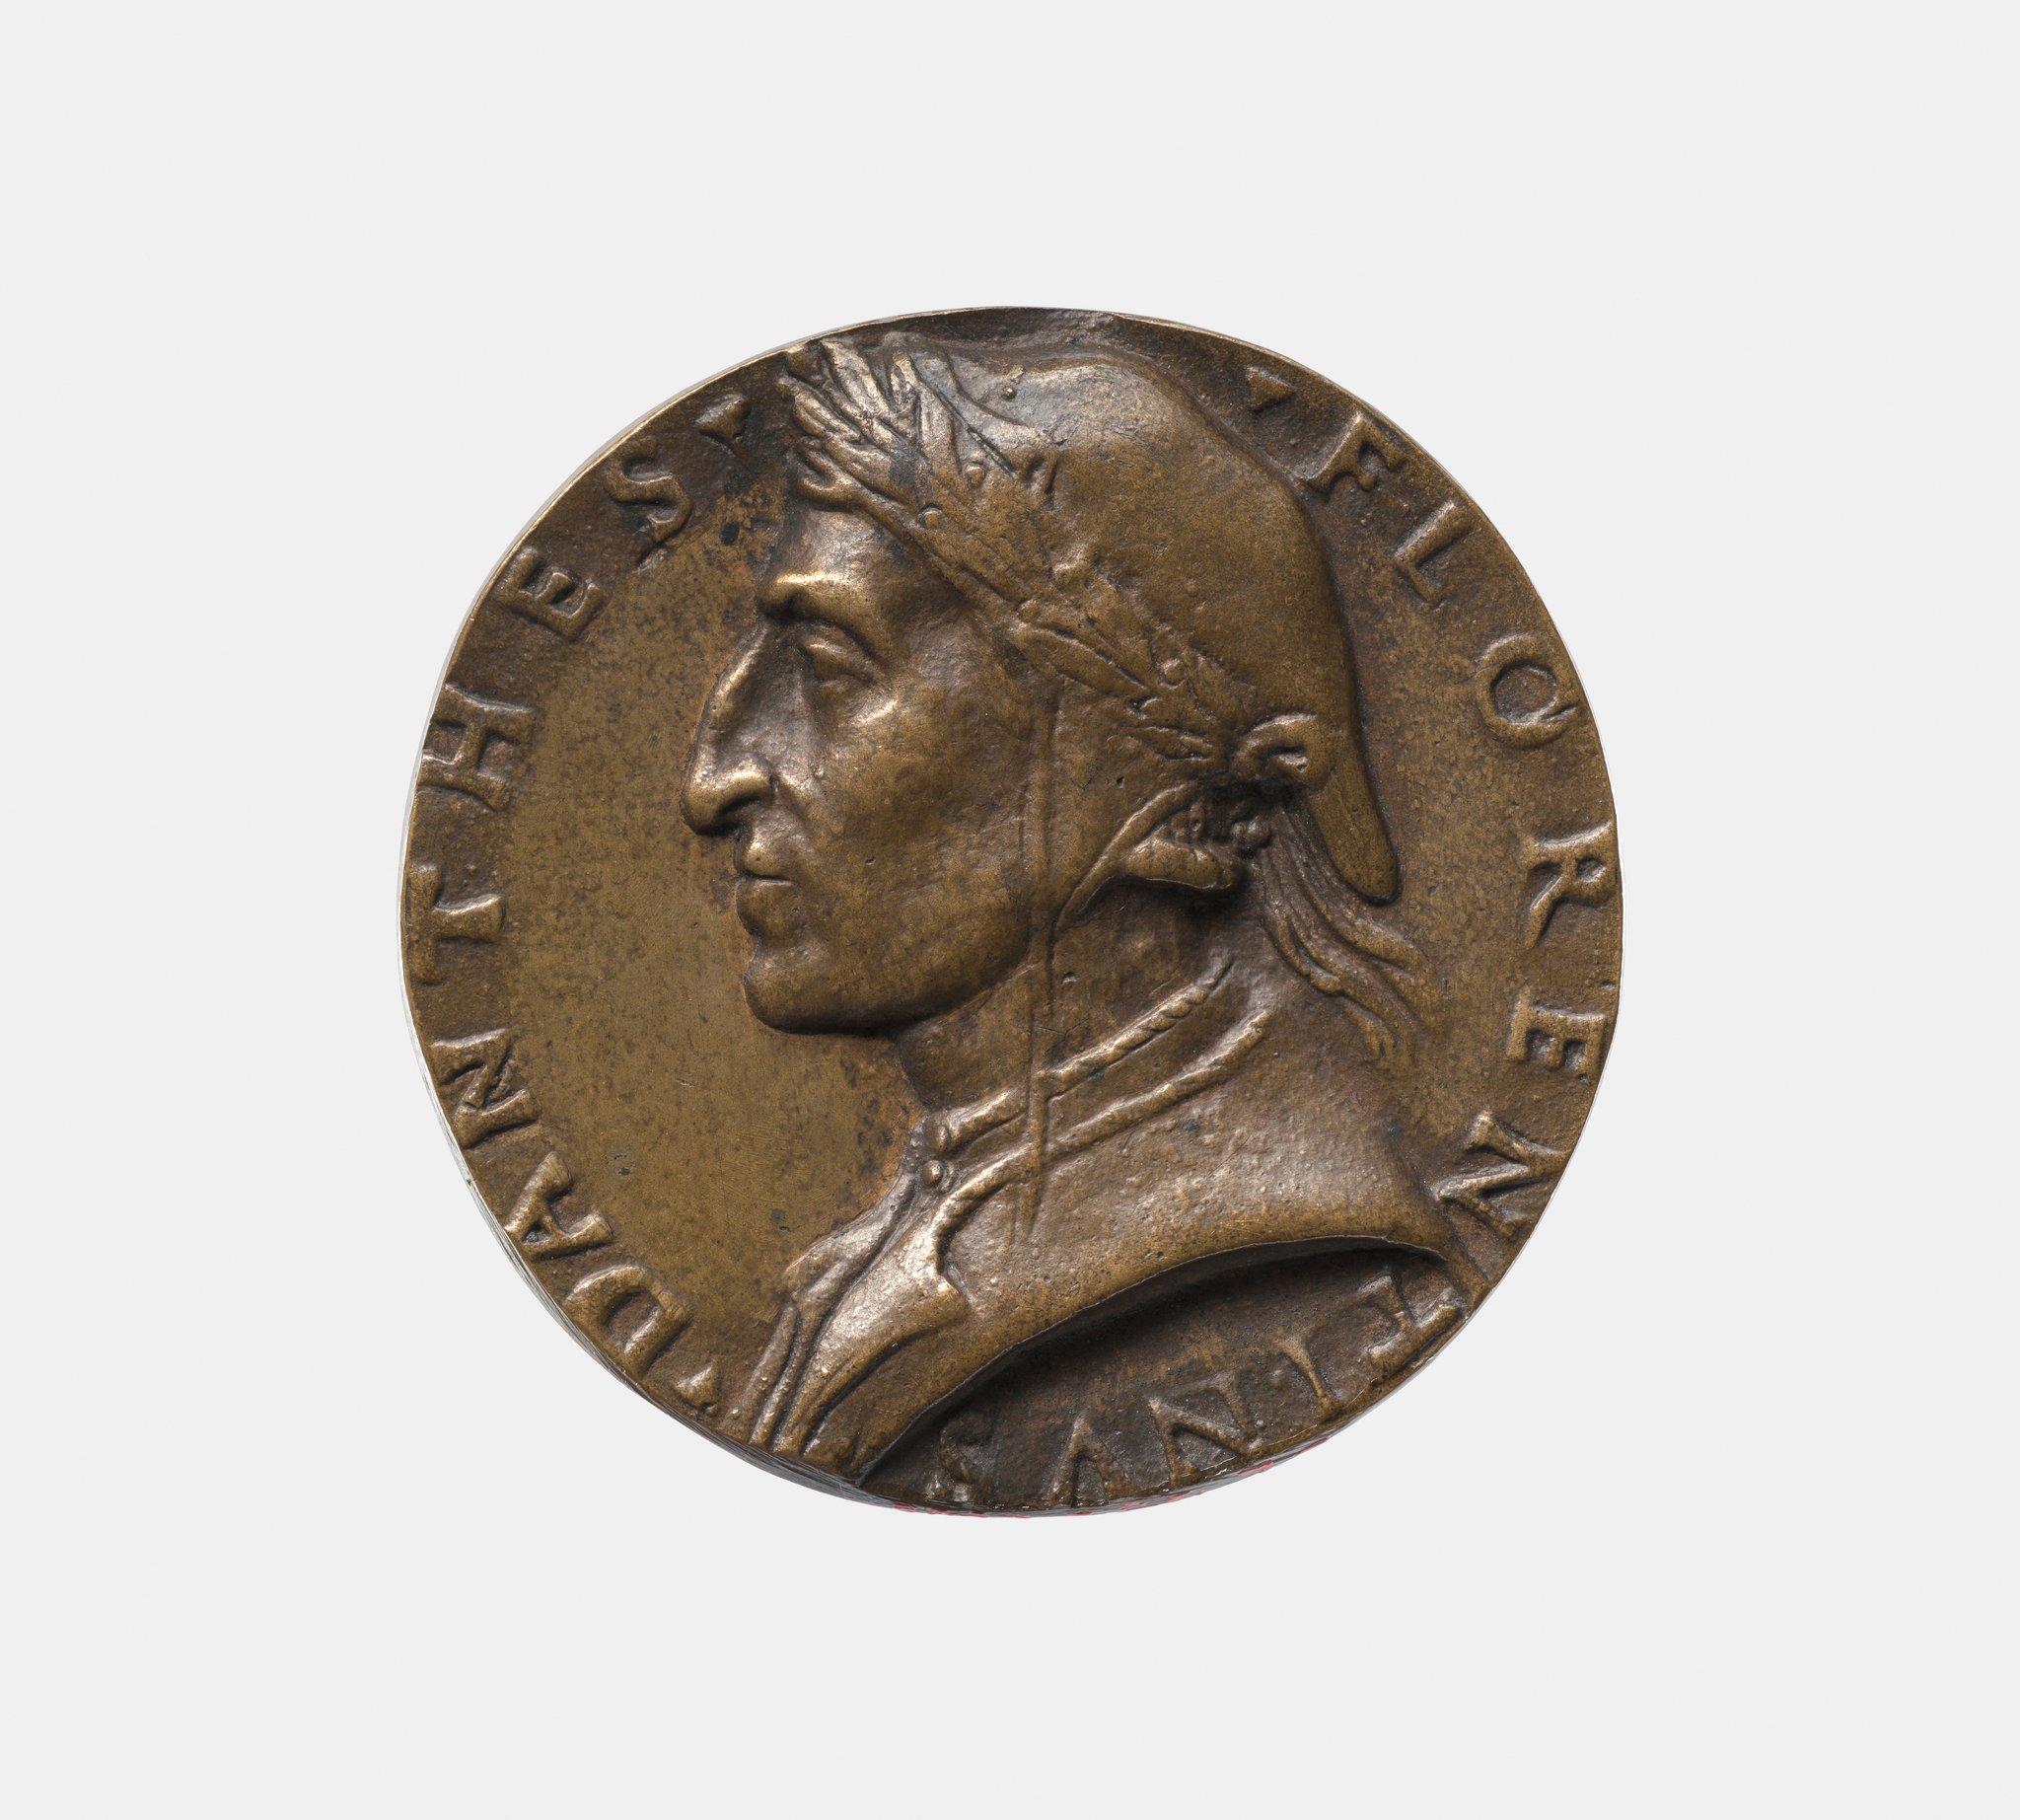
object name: medal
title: Dante Alighieri 1265-1321, Florentine poet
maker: Anonymous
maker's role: artist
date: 1475-1499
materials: bronze